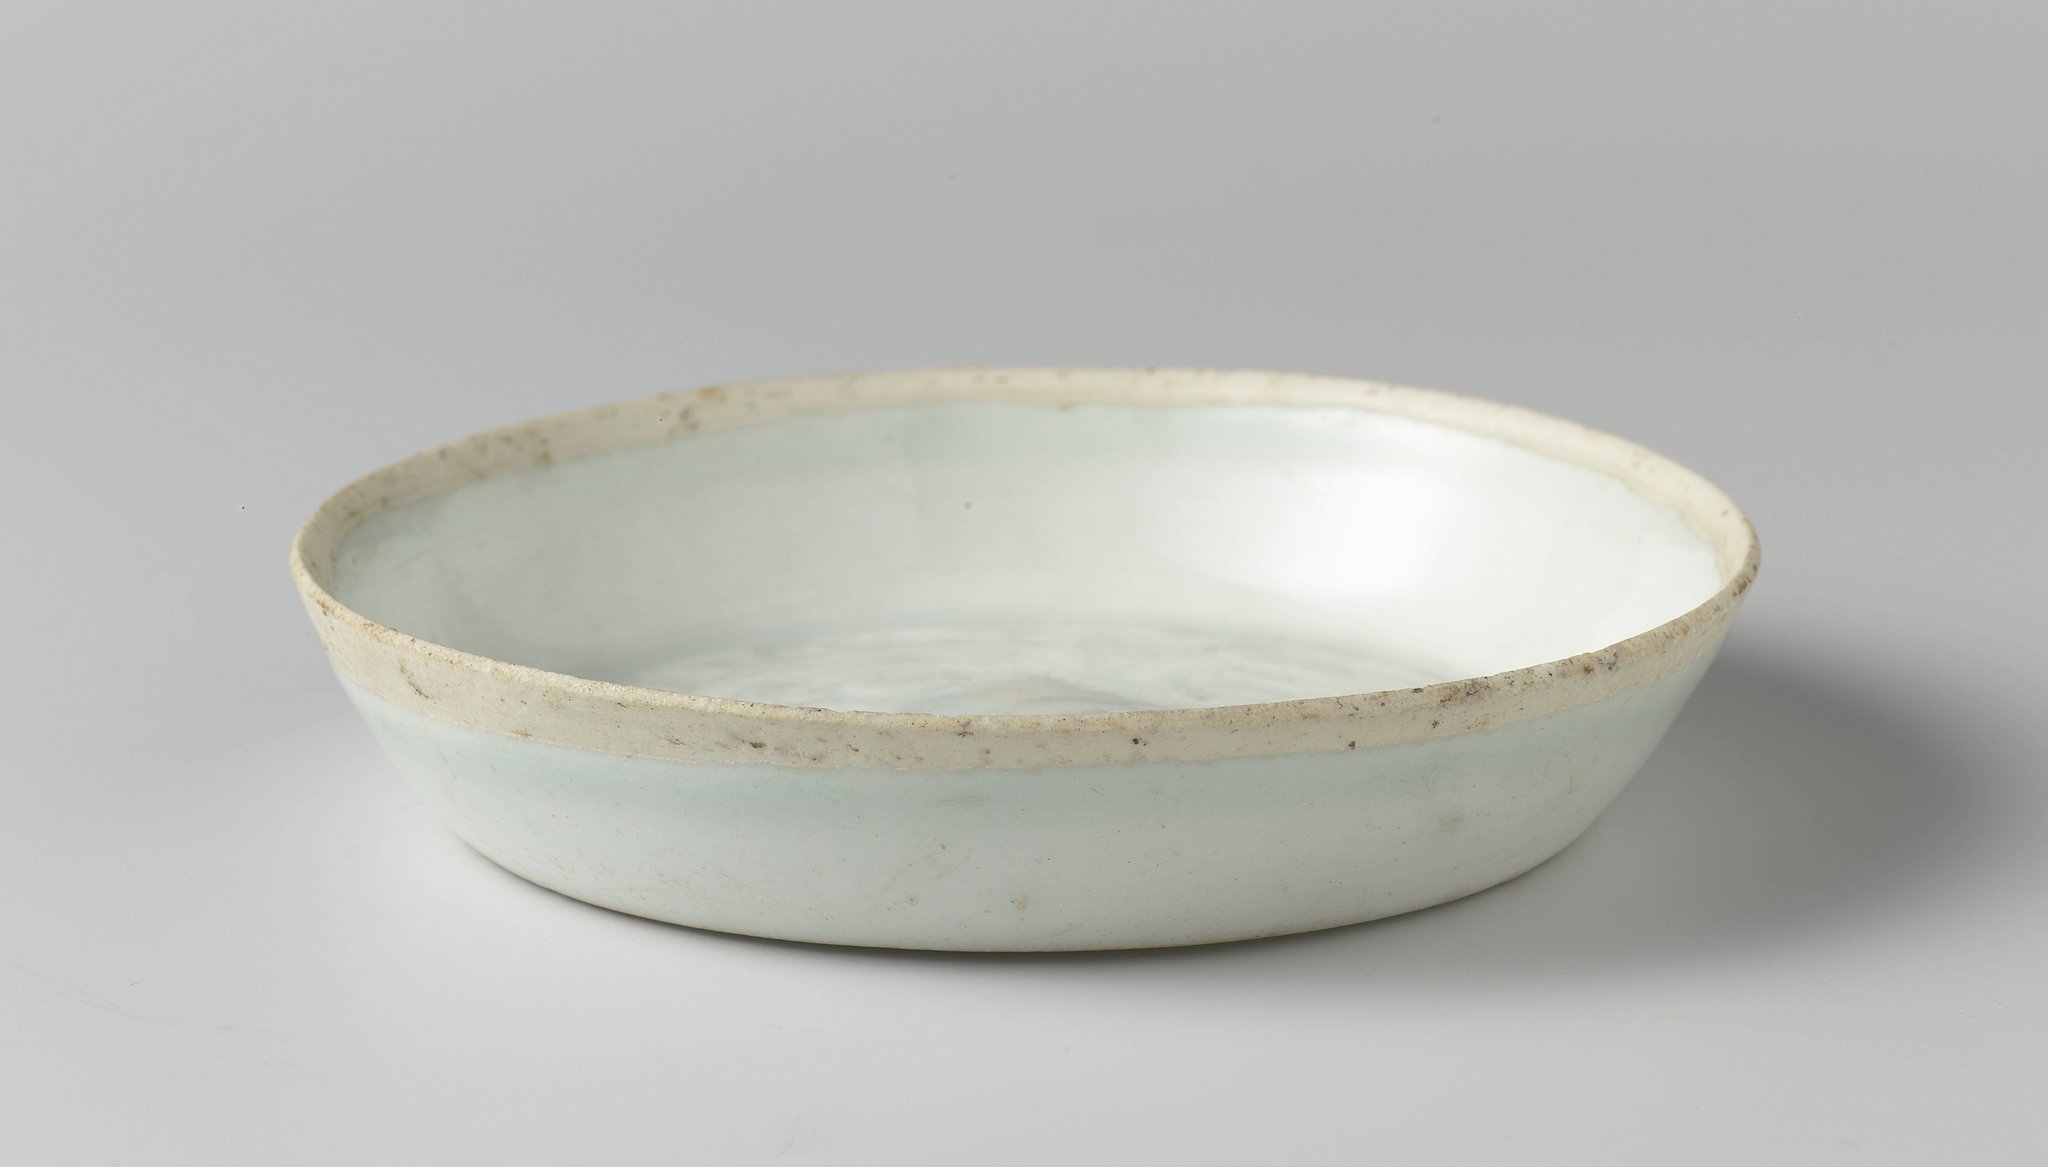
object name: dish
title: Saucer-dish with incised foliate scrolls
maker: Anonymous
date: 1127-1279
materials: glaze, stoneware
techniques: engraving, firing, turning, vitrification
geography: china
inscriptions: label: ‘W094’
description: Schaal van steengoed, bedekt met een transparant glazuur met een lichtblauwe tint. Op het plat ingegrifte bladranken. De rand is ongeglazuurd. Oud label op de onderzijde met 'W094'. Qingbai.